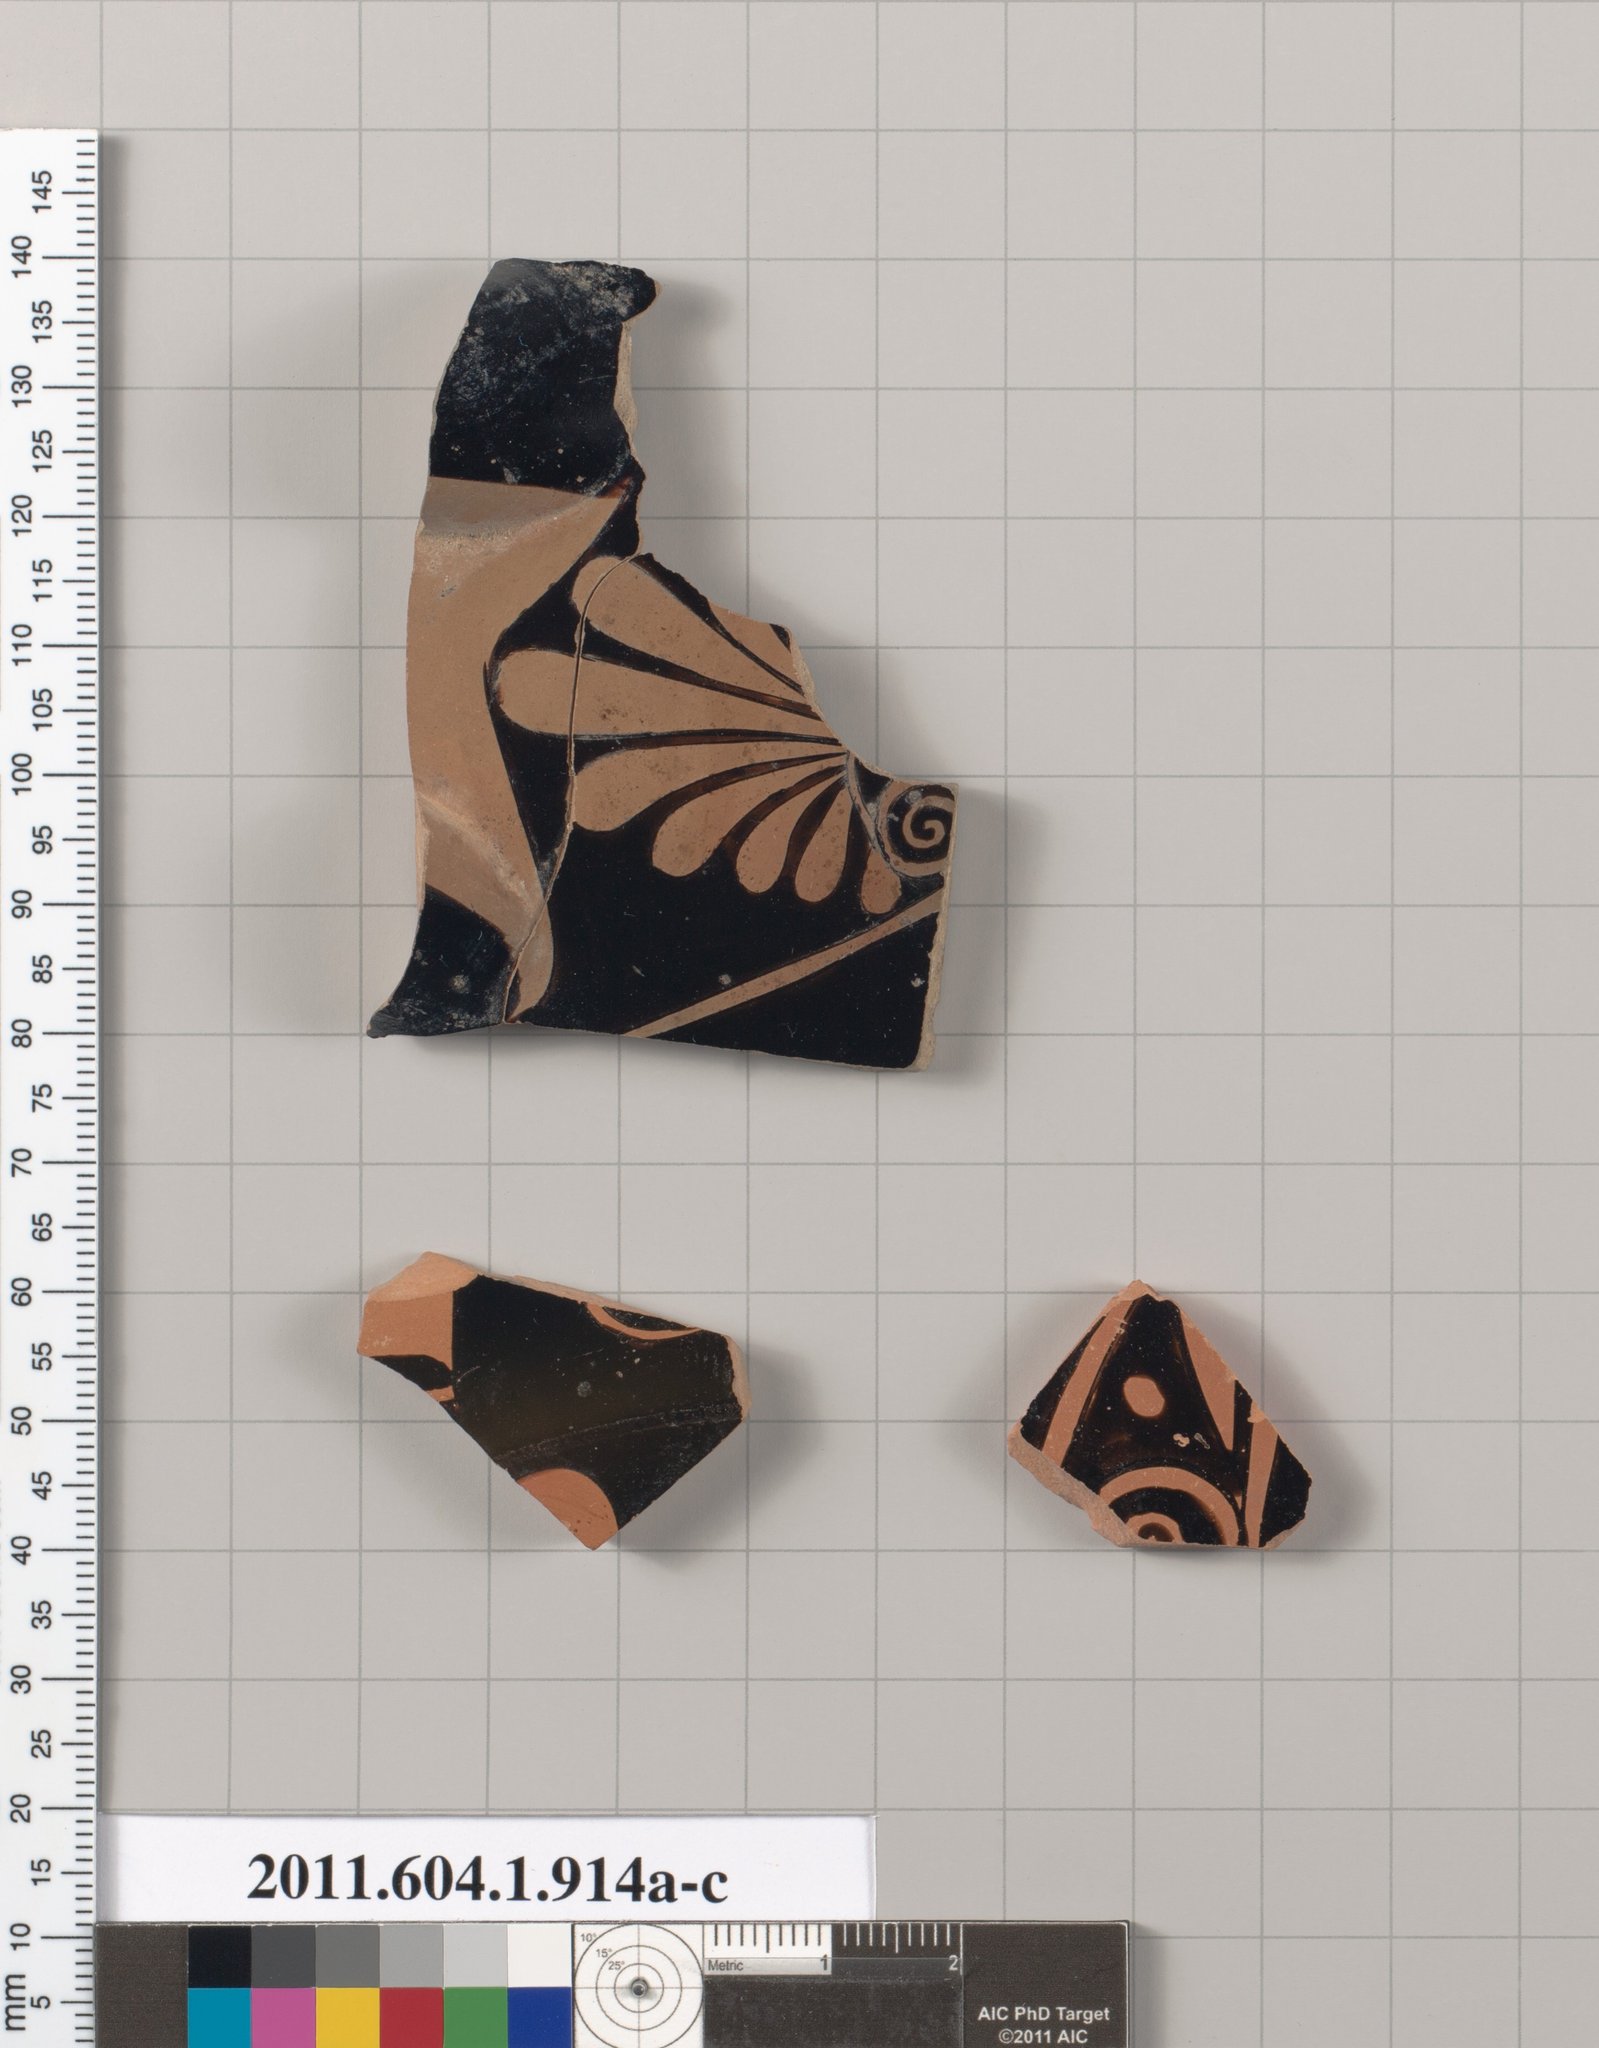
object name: kylix fragment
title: Terracotta fragments of kylikes (drinking cups)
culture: greek, attic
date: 500-451 BCE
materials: terracotta